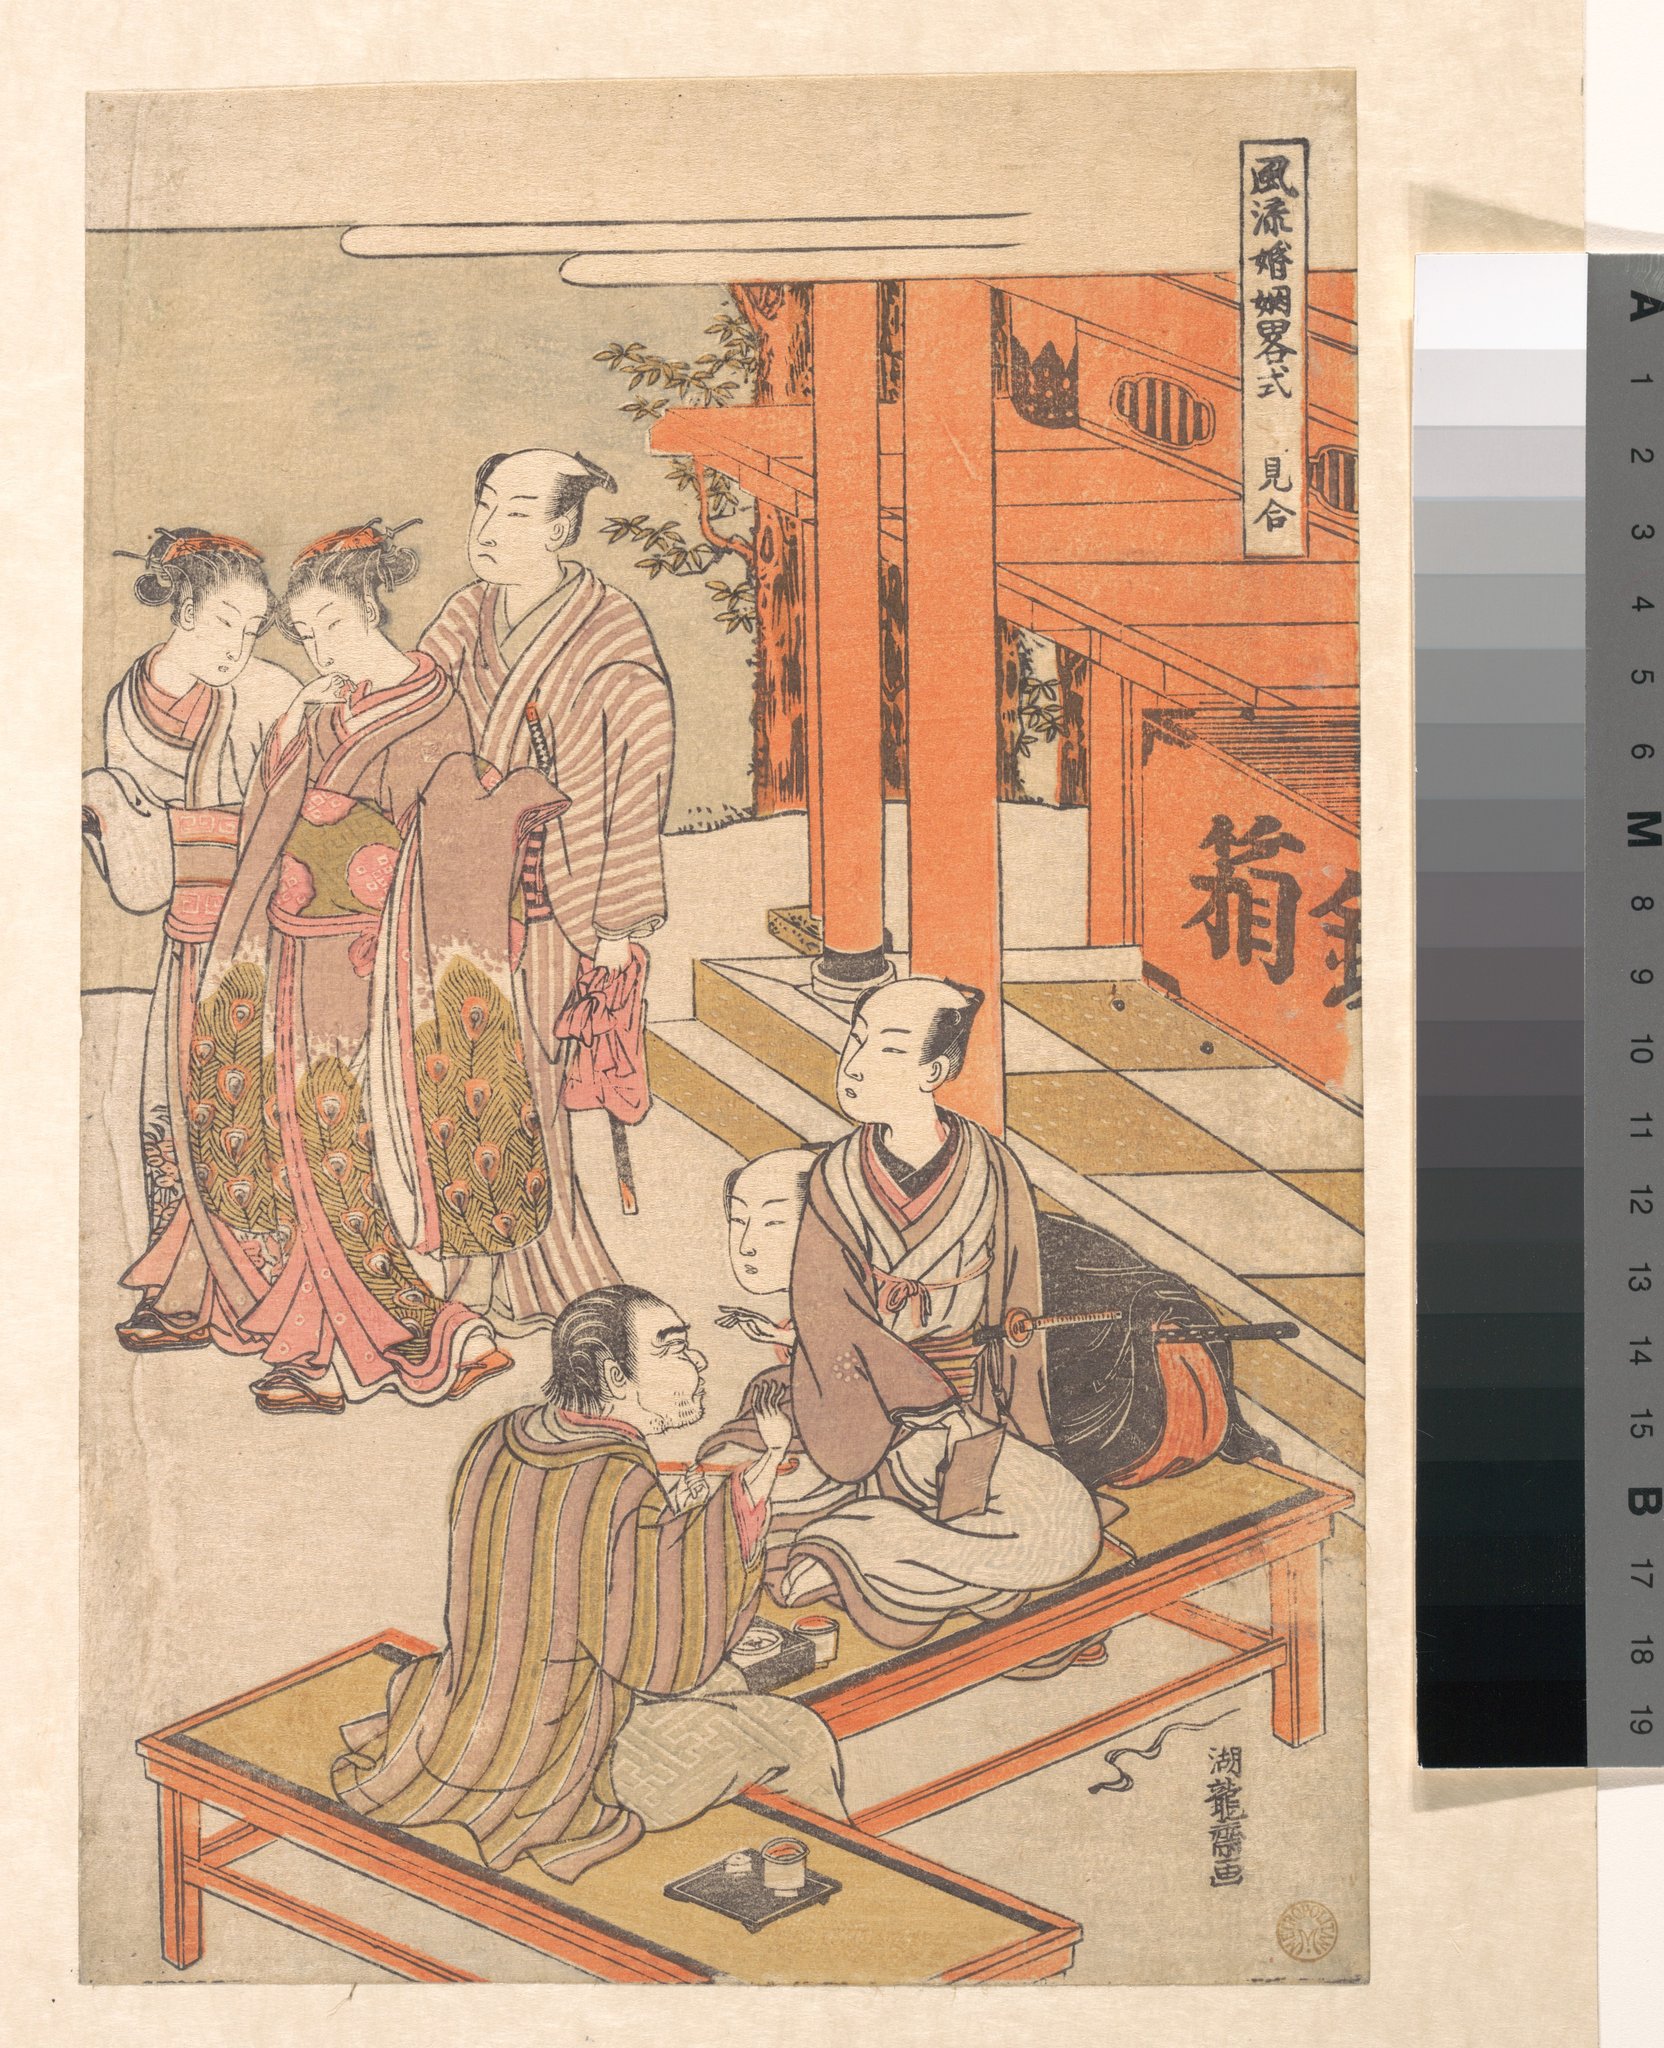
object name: print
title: Seeing Each Other with a View to Marriage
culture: japanese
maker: isoda koryūsai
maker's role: artist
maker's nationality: japanese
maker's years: 1735-1790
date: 1770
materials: ink, paper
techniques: woodblock print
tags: men,women,tea houses